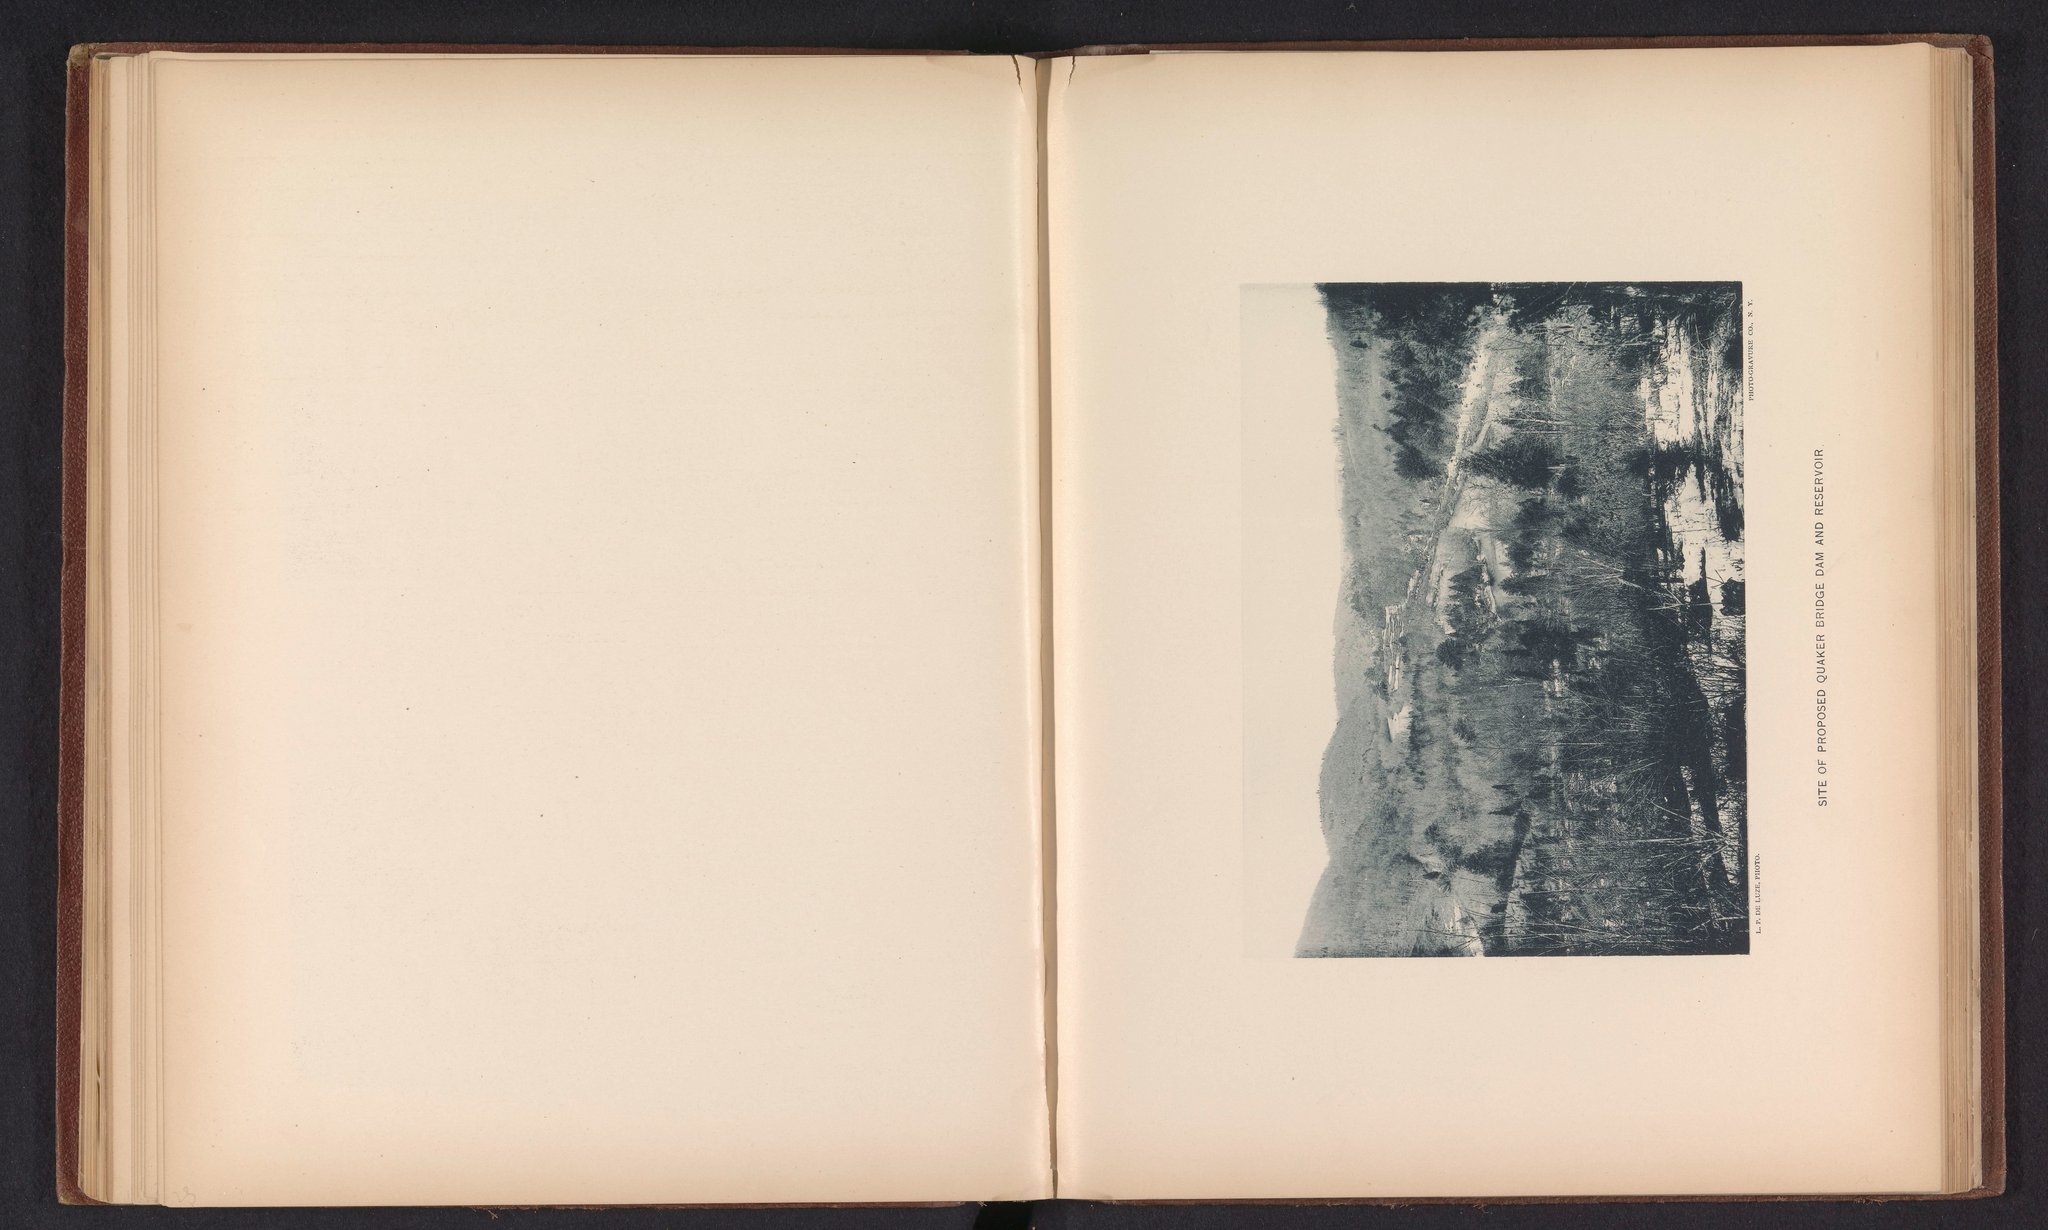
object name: photomechanical print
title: Site of proposed Quaker Bridge Dam and reservoir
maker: p. de luze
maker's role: fotograaf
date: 1883-1887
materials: paper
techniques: photograph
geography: new york city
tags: river